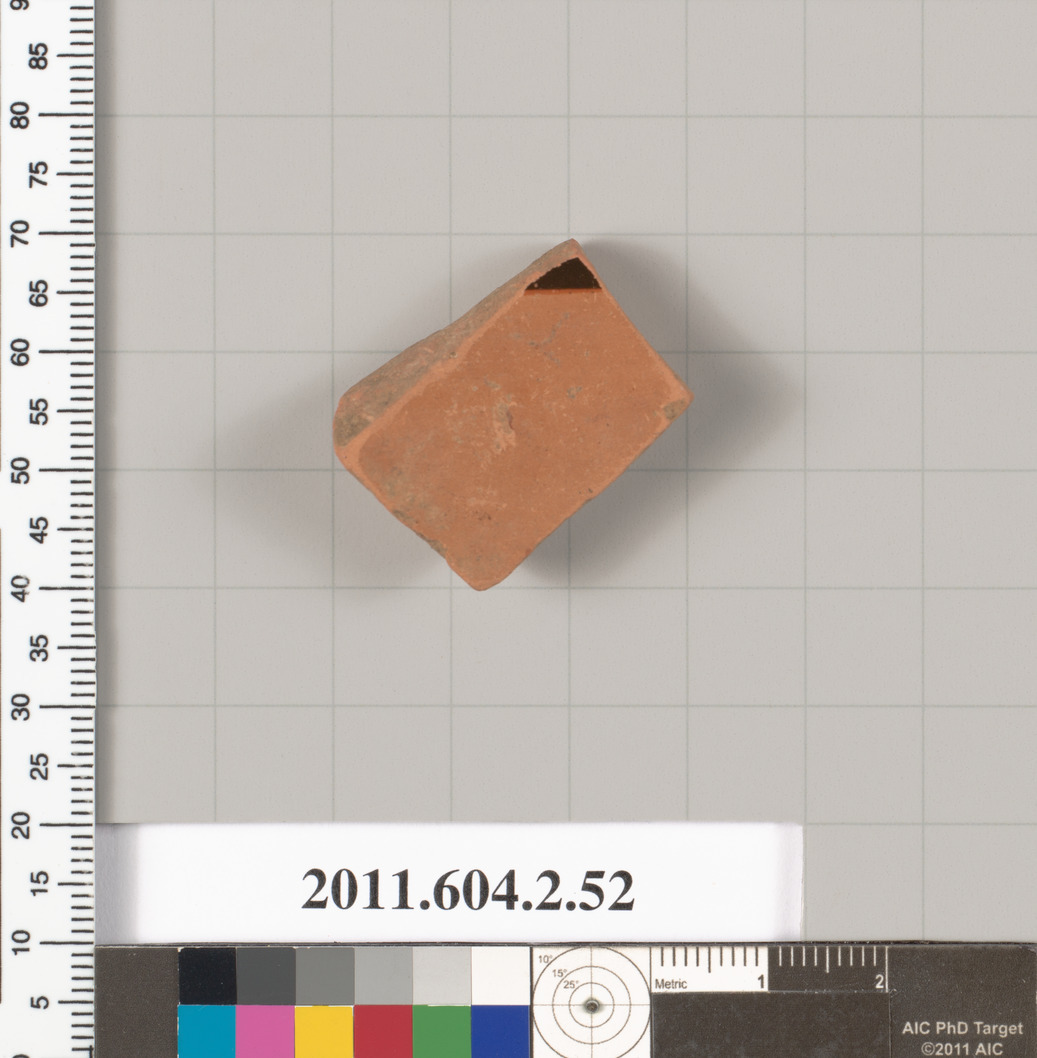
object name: pot fragment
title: Terracotta fragment of a pot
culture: greek, attic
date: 510-480 BCE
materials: terracotta